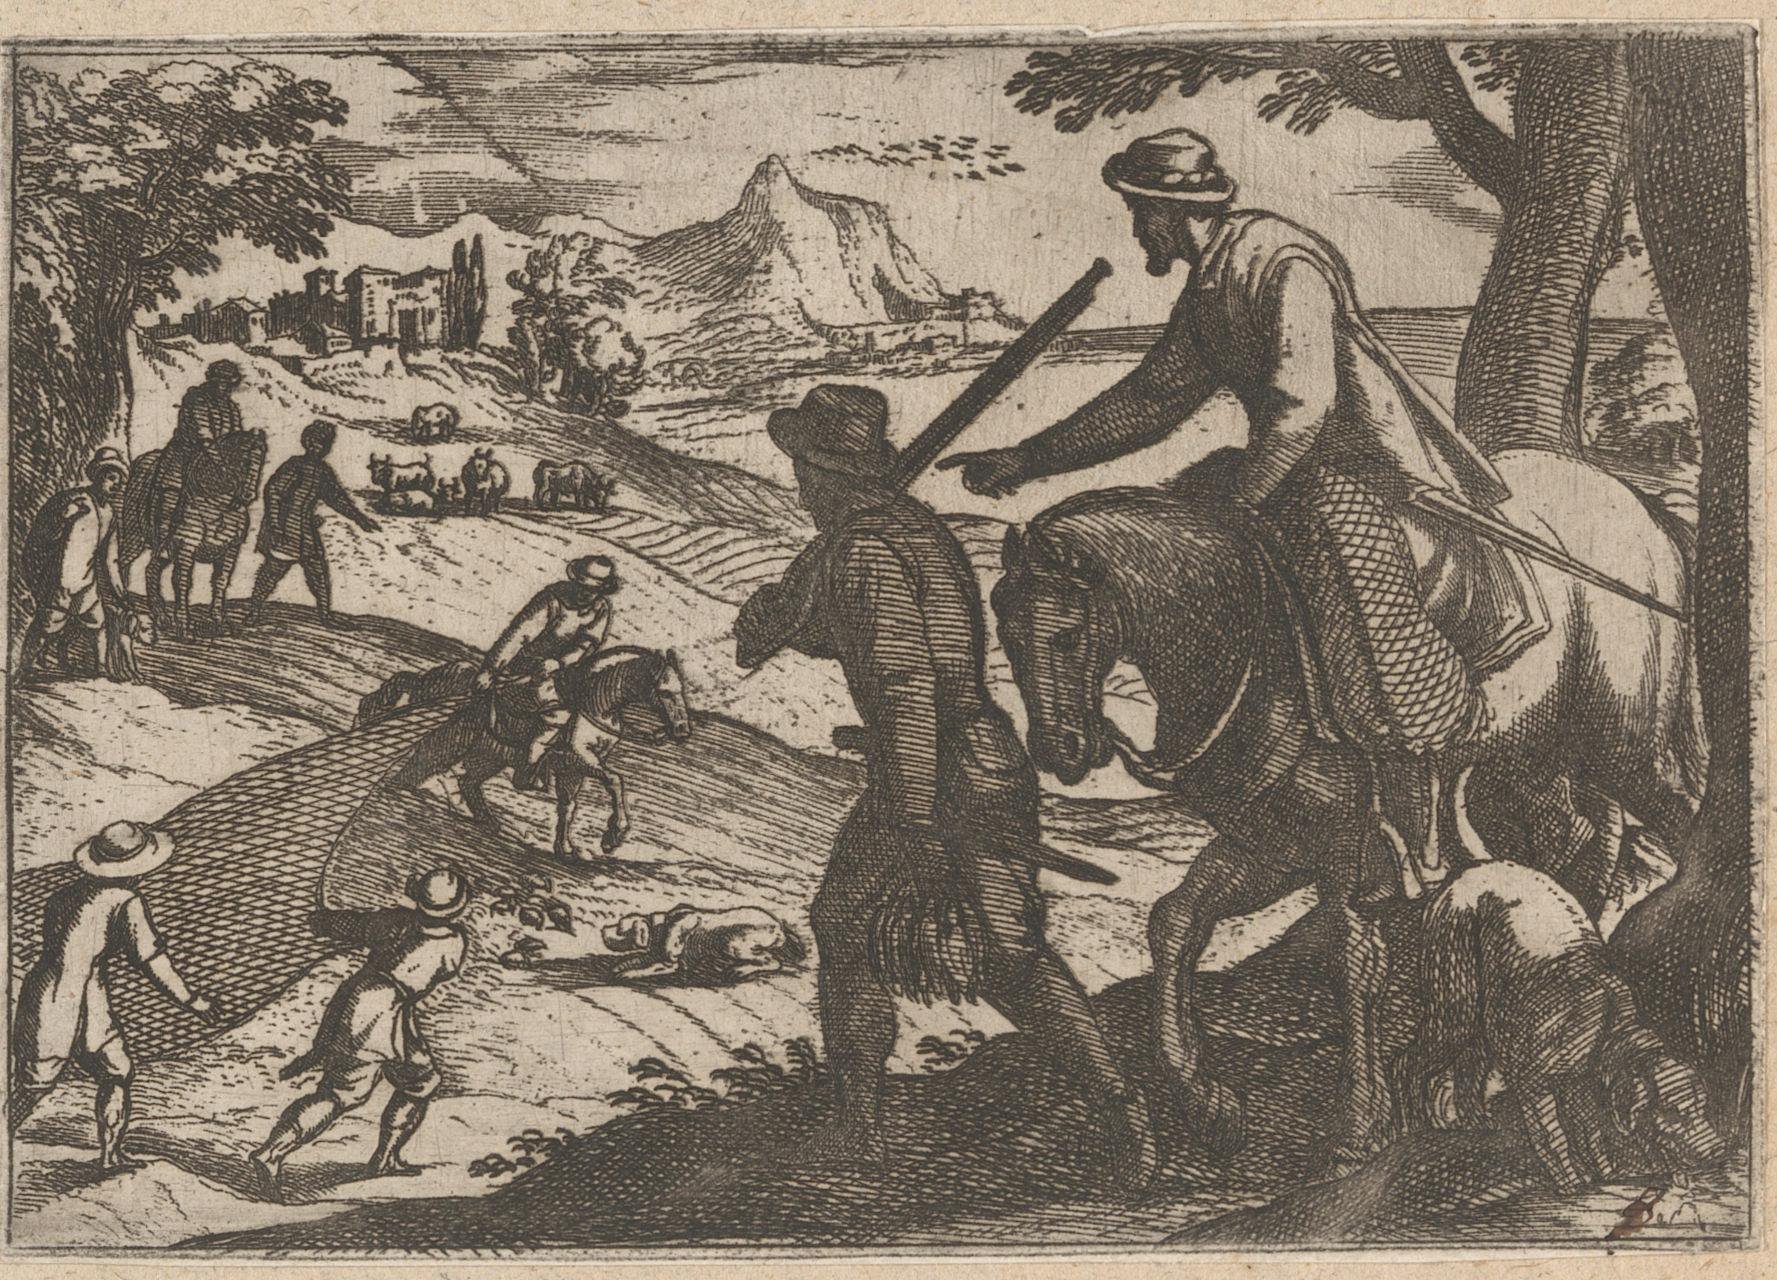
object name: print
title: Jagers vangen vogels met netten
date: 1598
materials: paper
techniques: etching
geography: italy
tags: hunter, hunters hunting (n.b.: in 1988-1990 this notation denoted the concept of 43c11421 'hunters resting during the hunt'), bird hunting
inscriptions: collector's mark: ‘Hinloopen’, number: ‘8’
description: Landschap met jagers die met behulp van een net en een jachthond vogels vangen. Op de voorgrond een jager te paard.